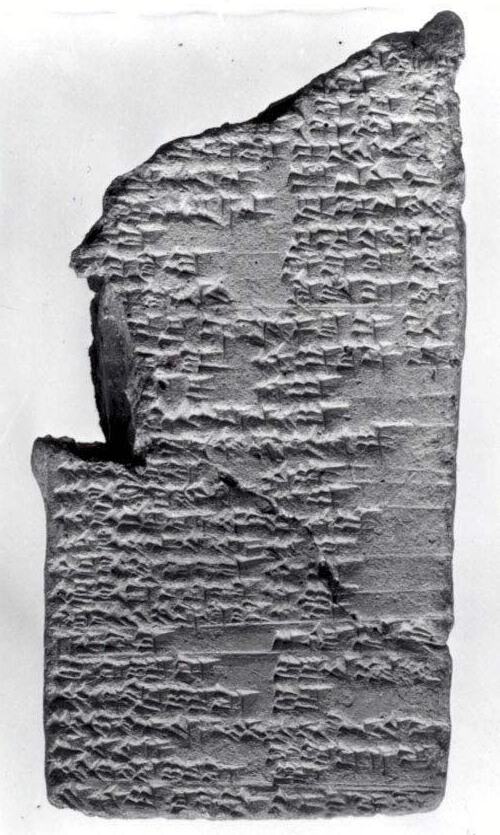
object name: cuneiform tablet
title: Cuneiform tablet: collection of ershemmas (nos. 45, 59, 53)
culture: parthian or seleucid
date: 367-400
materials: clay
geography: mesopotamia